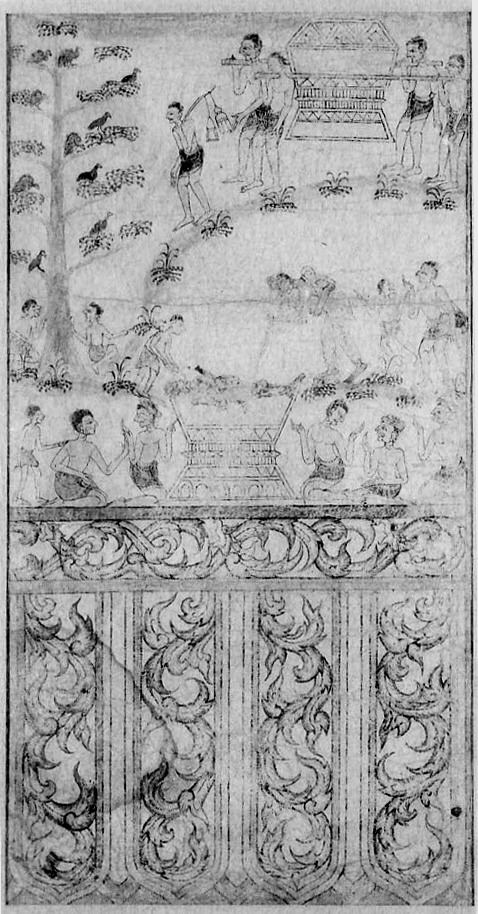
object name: painting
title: Cremation of Jujaka's Body(?): Scene from Vessantara Jataka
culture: thai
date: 1801-2000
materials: paper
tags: men